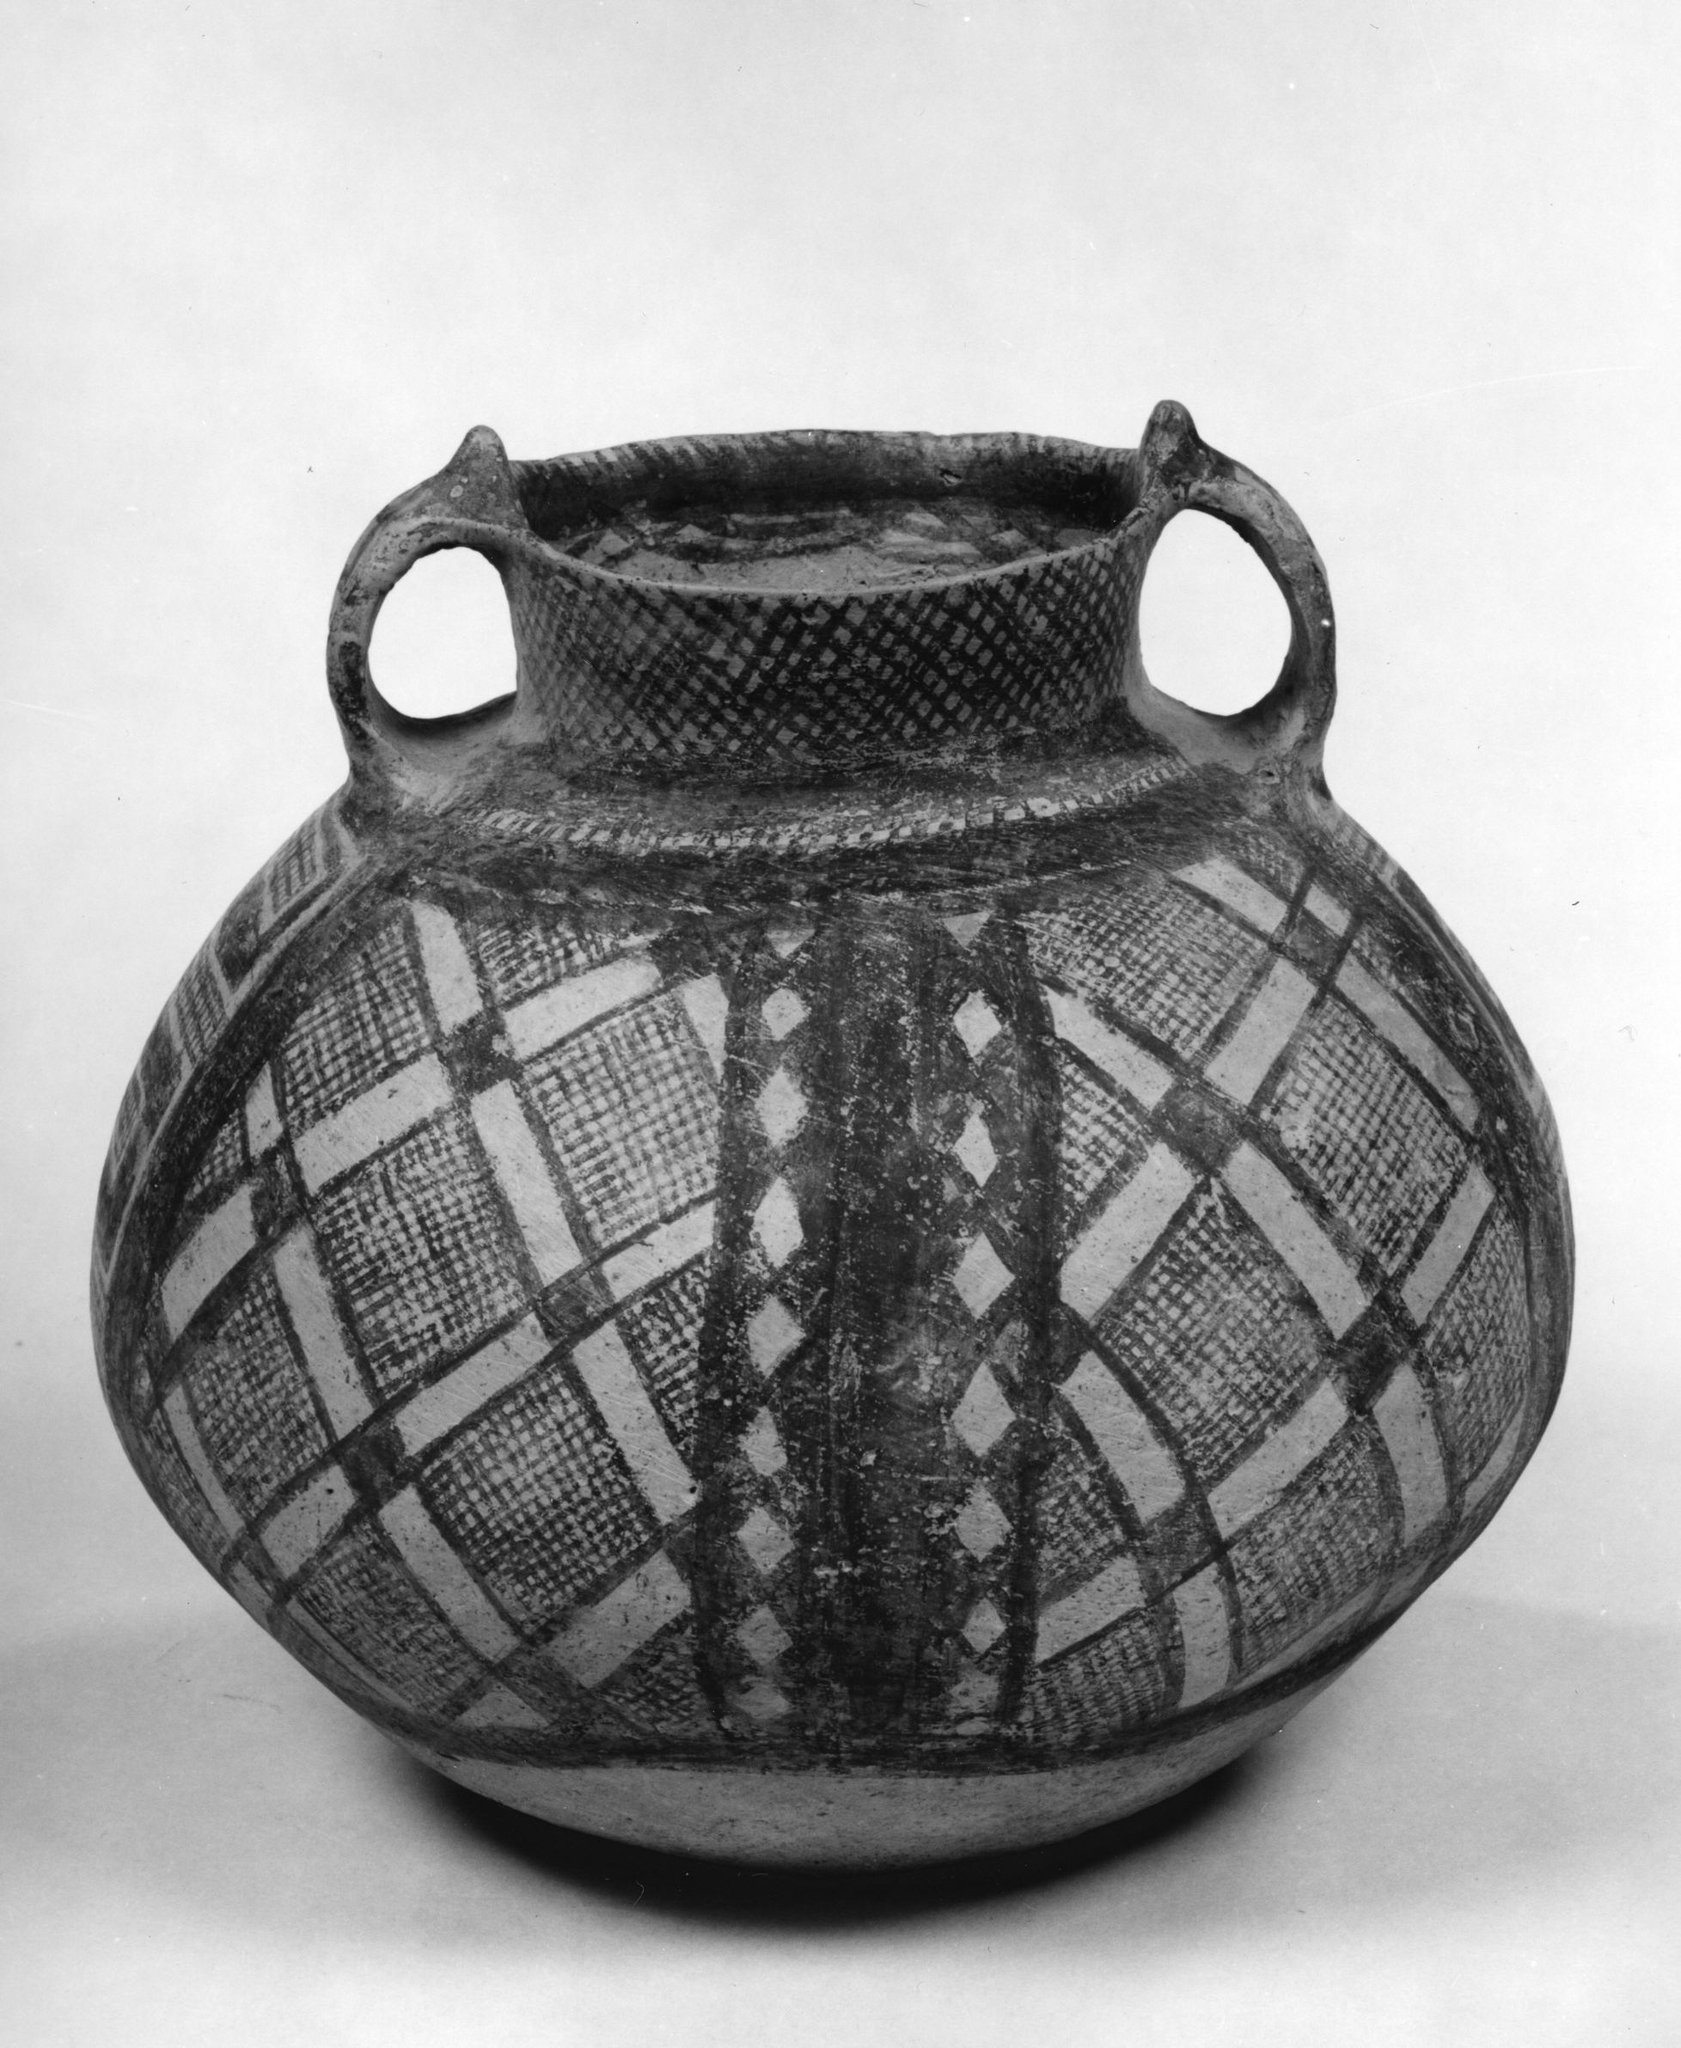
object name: jar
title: Jar (Guan)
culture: chinese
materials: earthenware, pigment